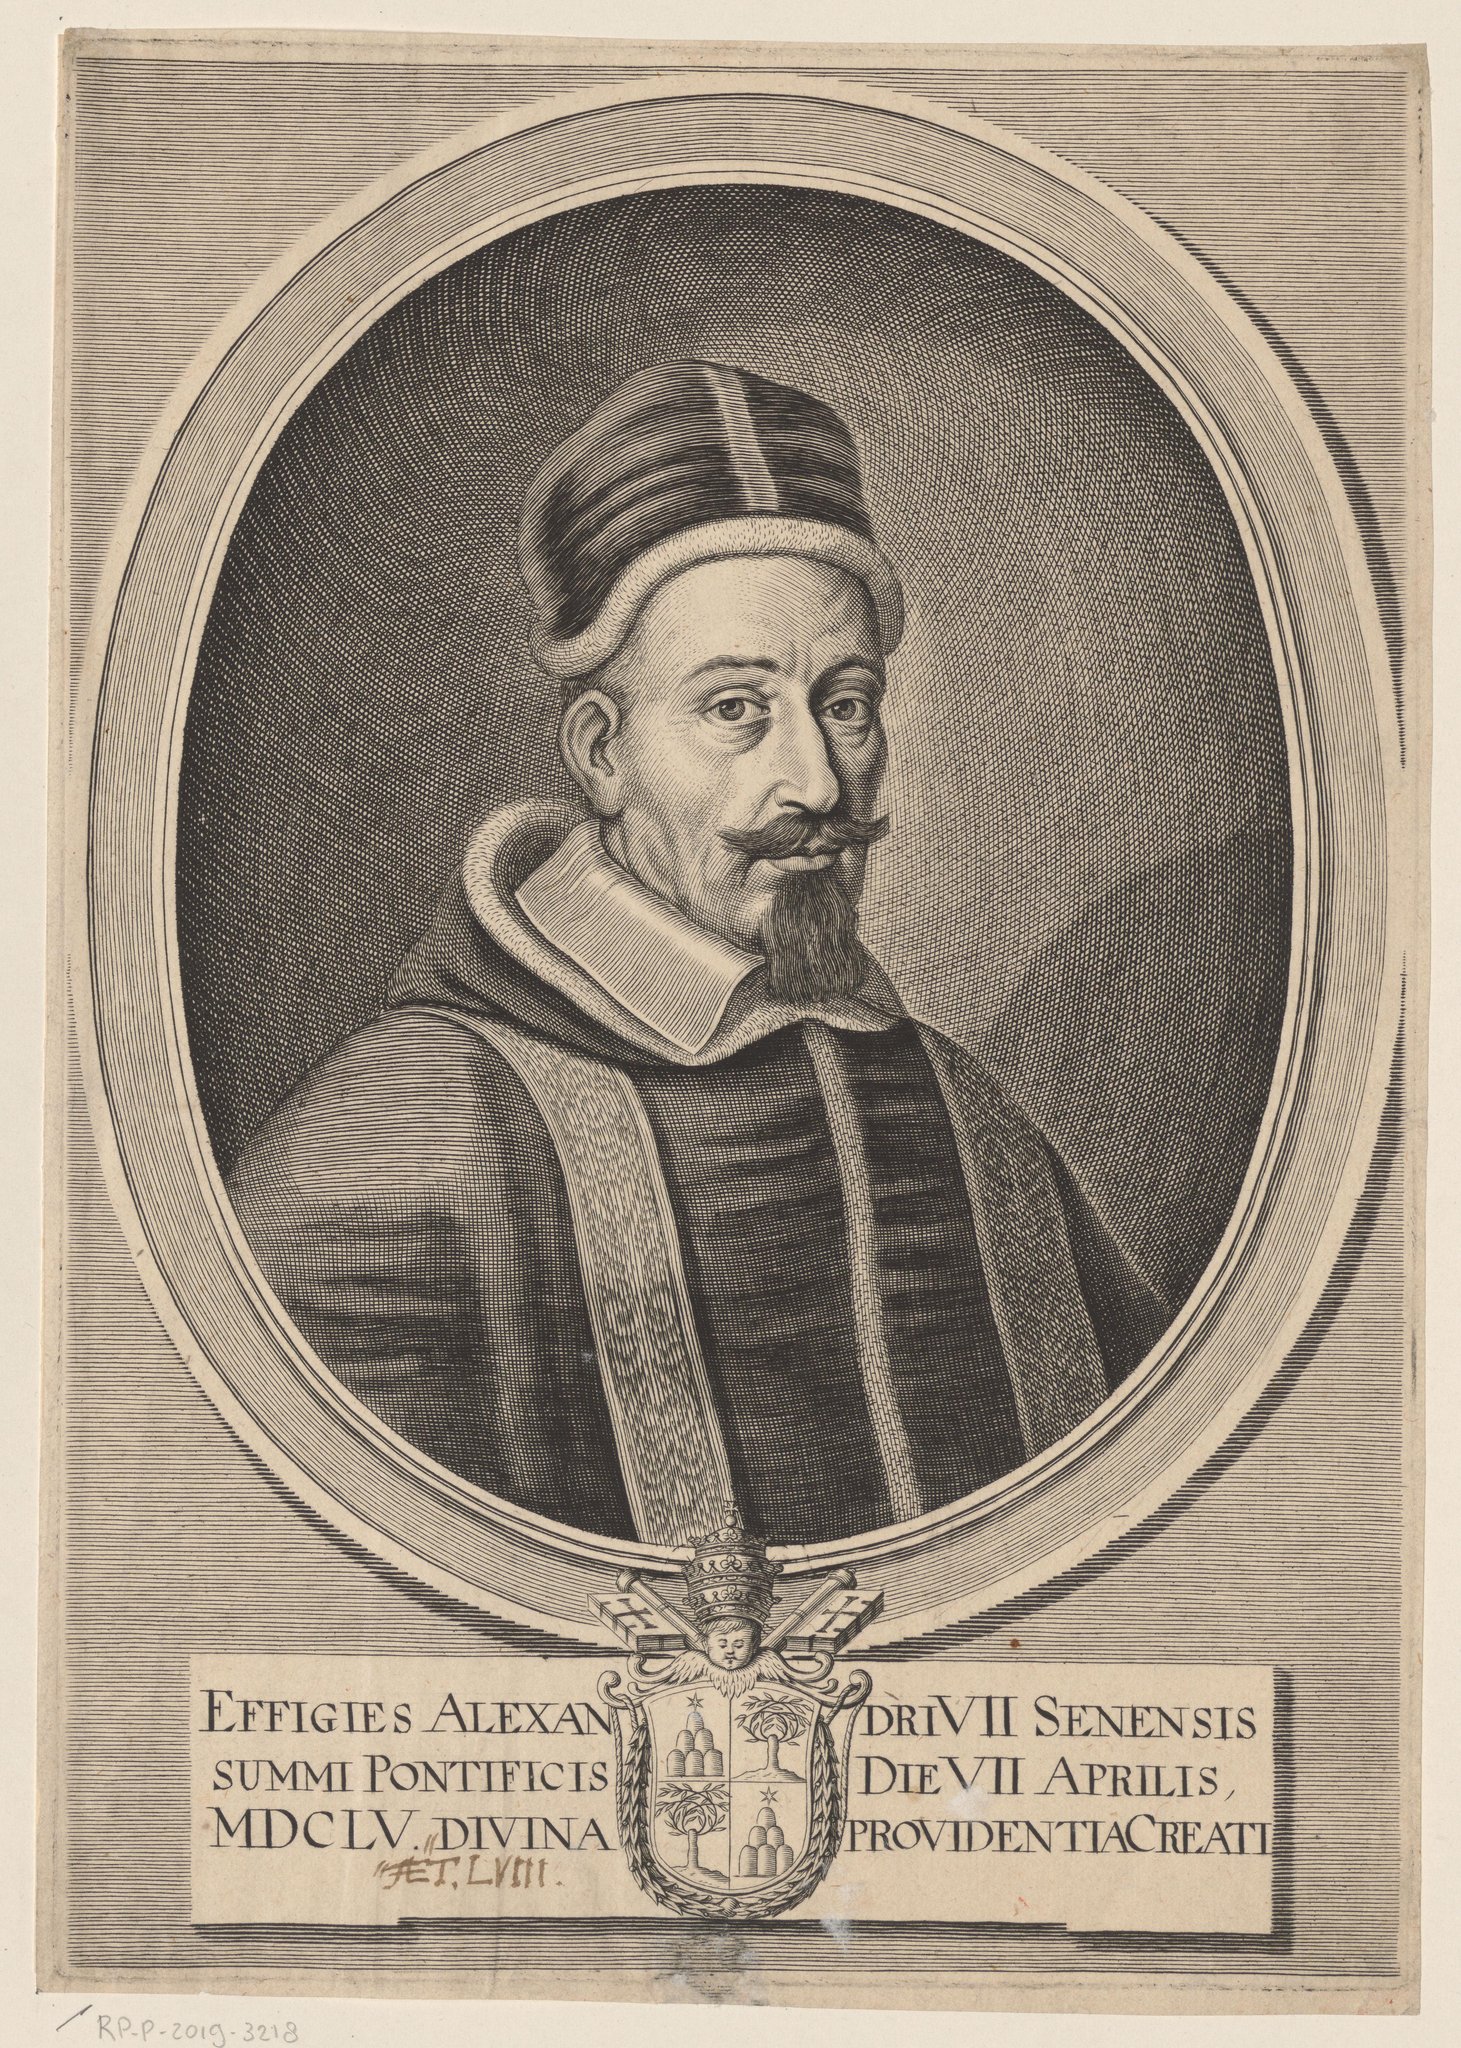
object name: print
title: Portret van Fabius Chisius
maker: Anonymous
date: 1648-1655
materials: paper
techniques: etching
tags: rome, alexander vii, historical persons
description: Kardinaal Fabius Chisius (Fabio Chigi), later paus Alexander VII.